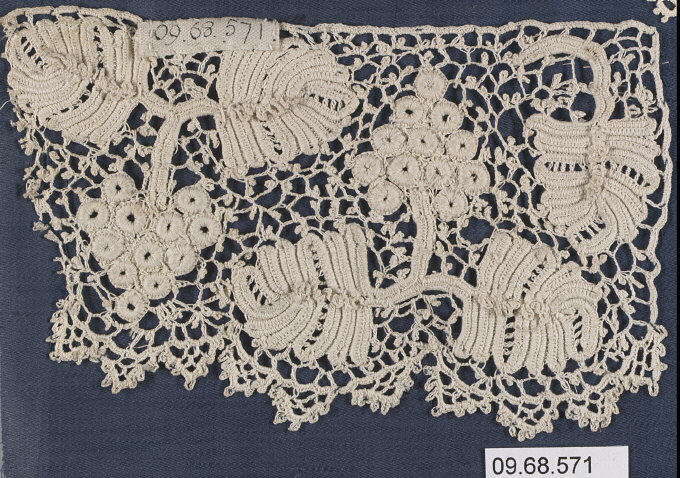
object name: specimen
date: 1801-1900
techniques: crochet